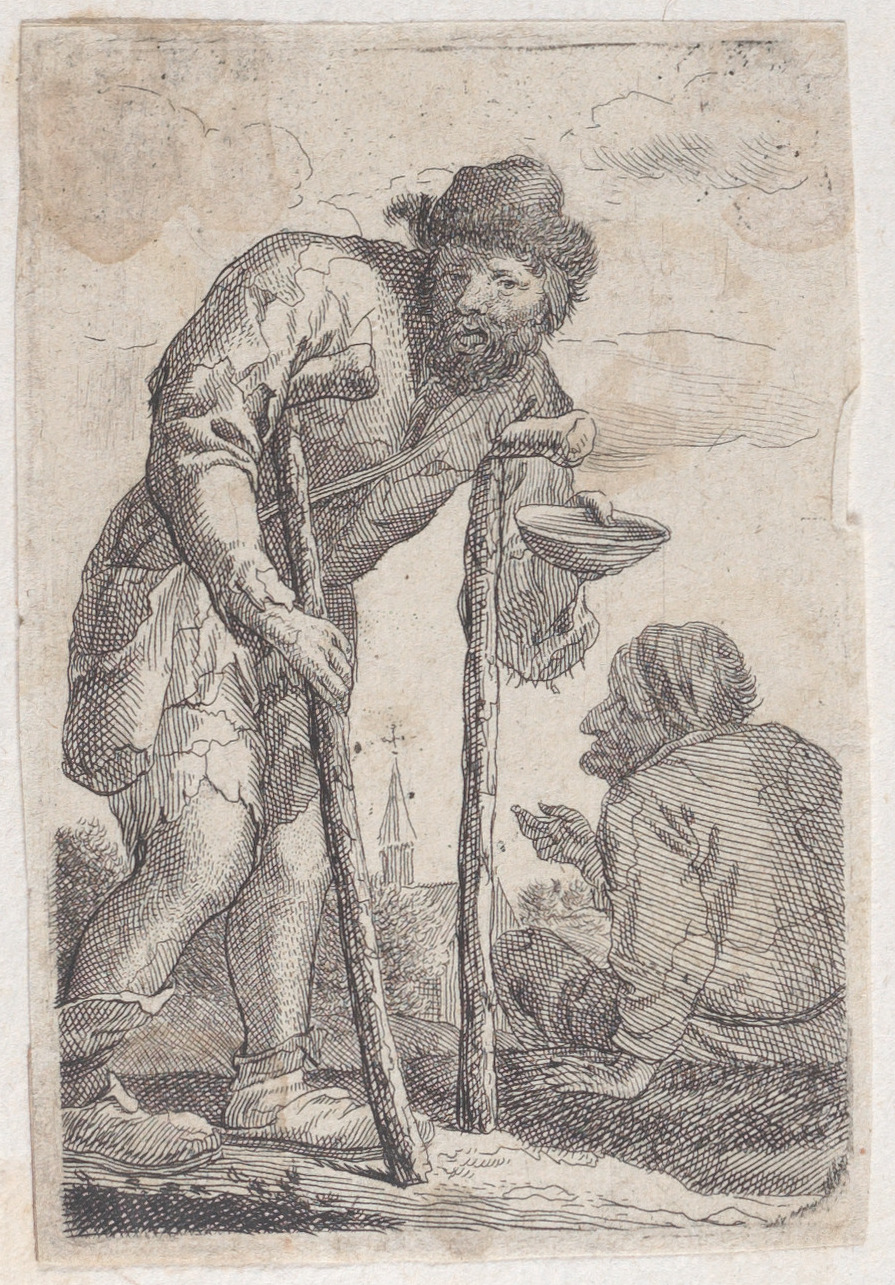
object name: print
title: A beggar on crutches holding out a bowl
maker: jacques dassonville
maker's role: artist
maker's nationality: french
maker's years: 1614-1675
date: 1640-1670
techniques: etching